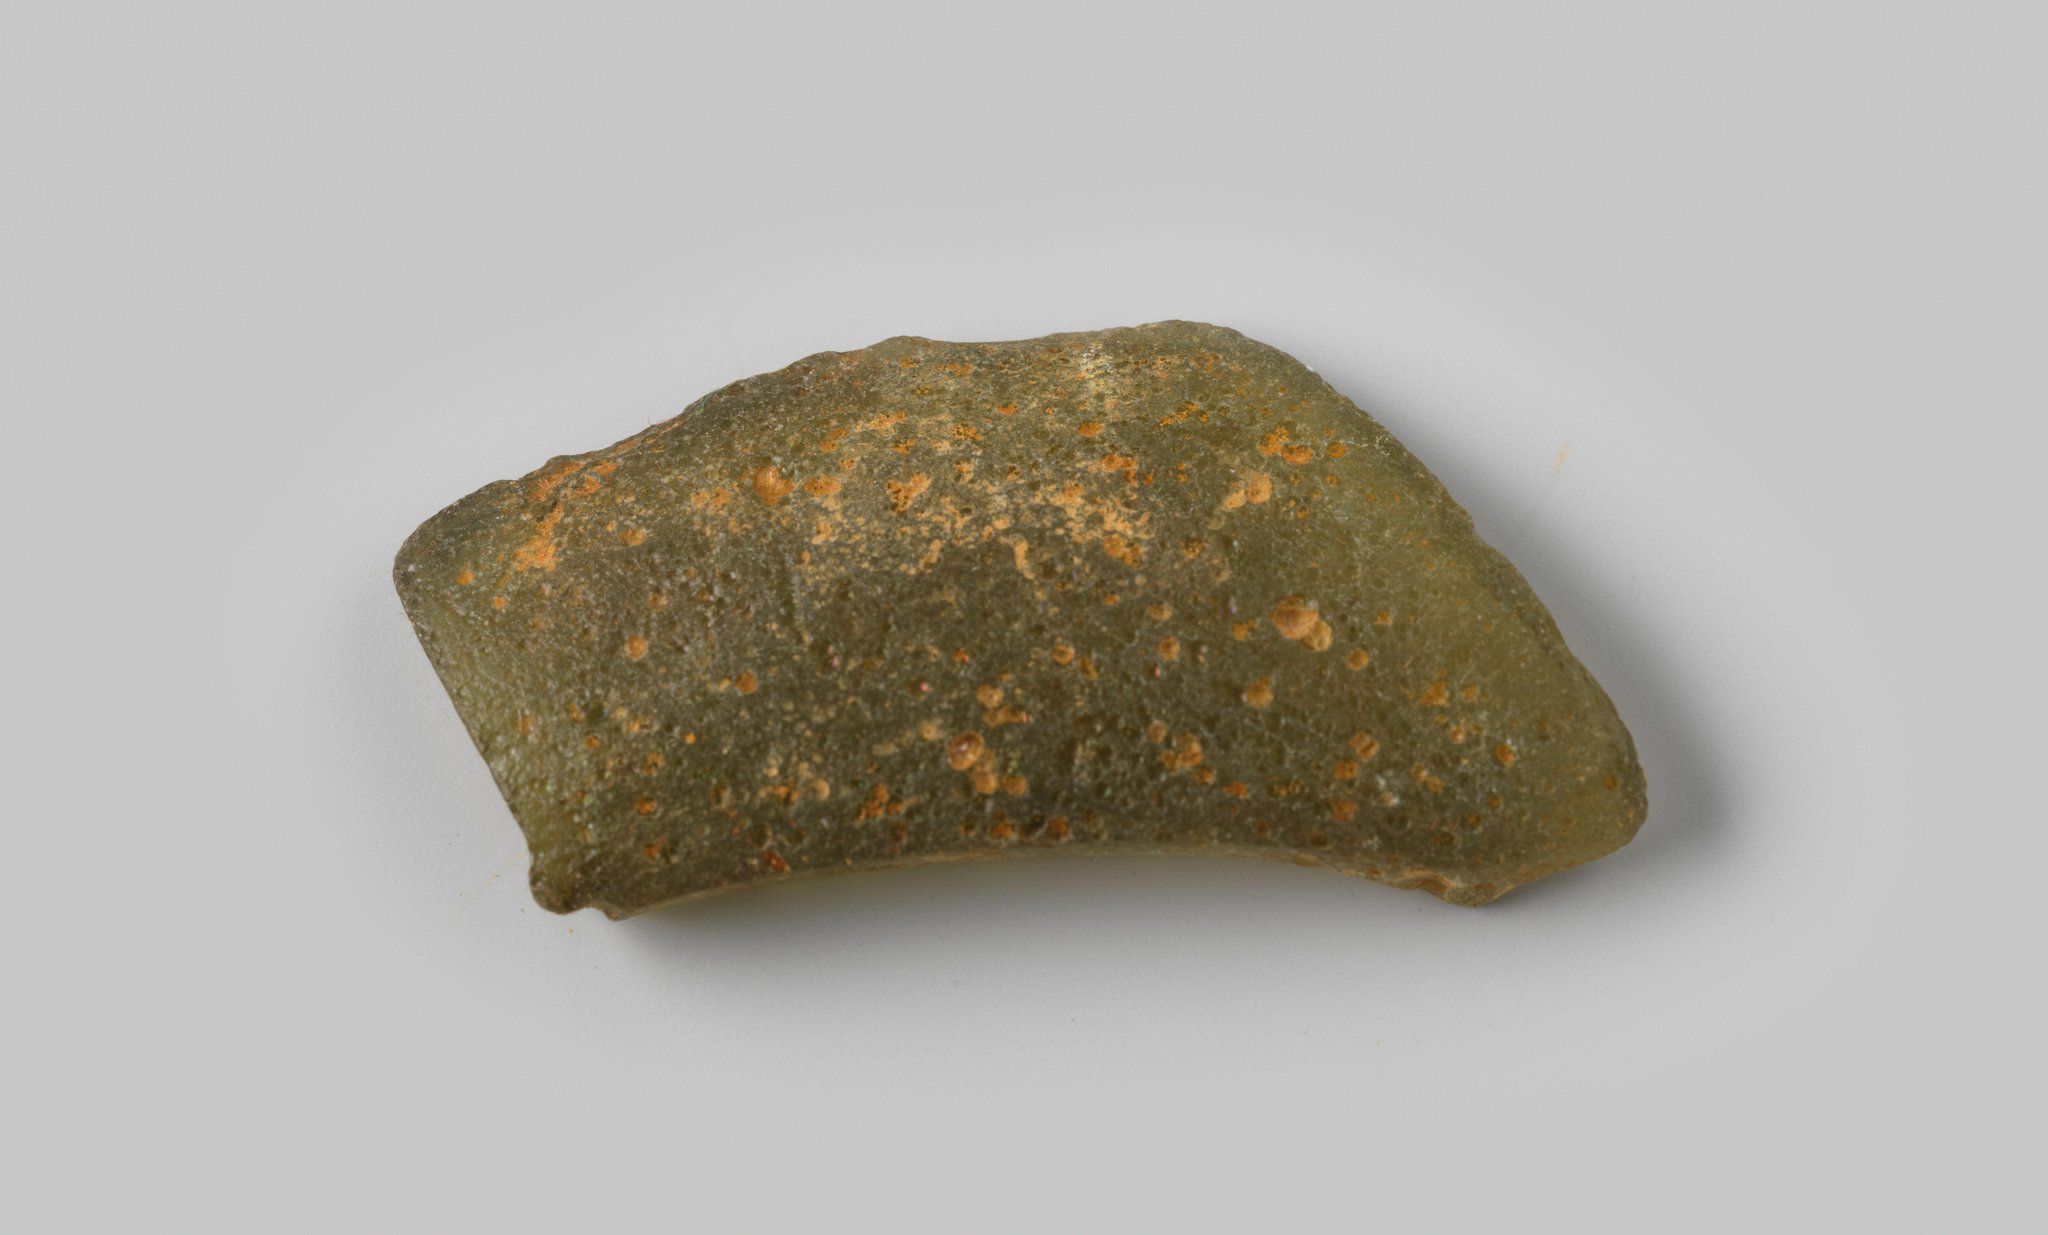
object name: wine bottle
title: Scherf van een wijnfles uit het wrak van de Oost-Indiëvaarder Hollandia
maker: Anonymous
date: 1700-1743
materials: glass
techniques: green glass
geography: netherlands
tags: verenigde oostindische compagnie, hollandia (schip), annet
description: Typologically not identifiable, belly, fragment.